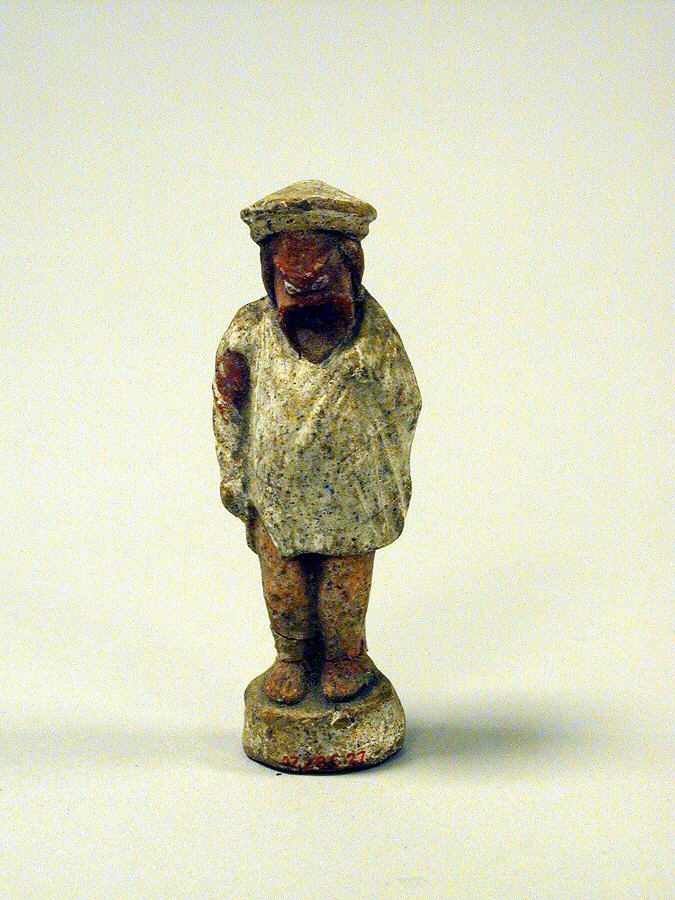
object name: statuette of an actor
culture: greek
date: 400-301 BCE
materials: terracotta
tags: human figures,actors